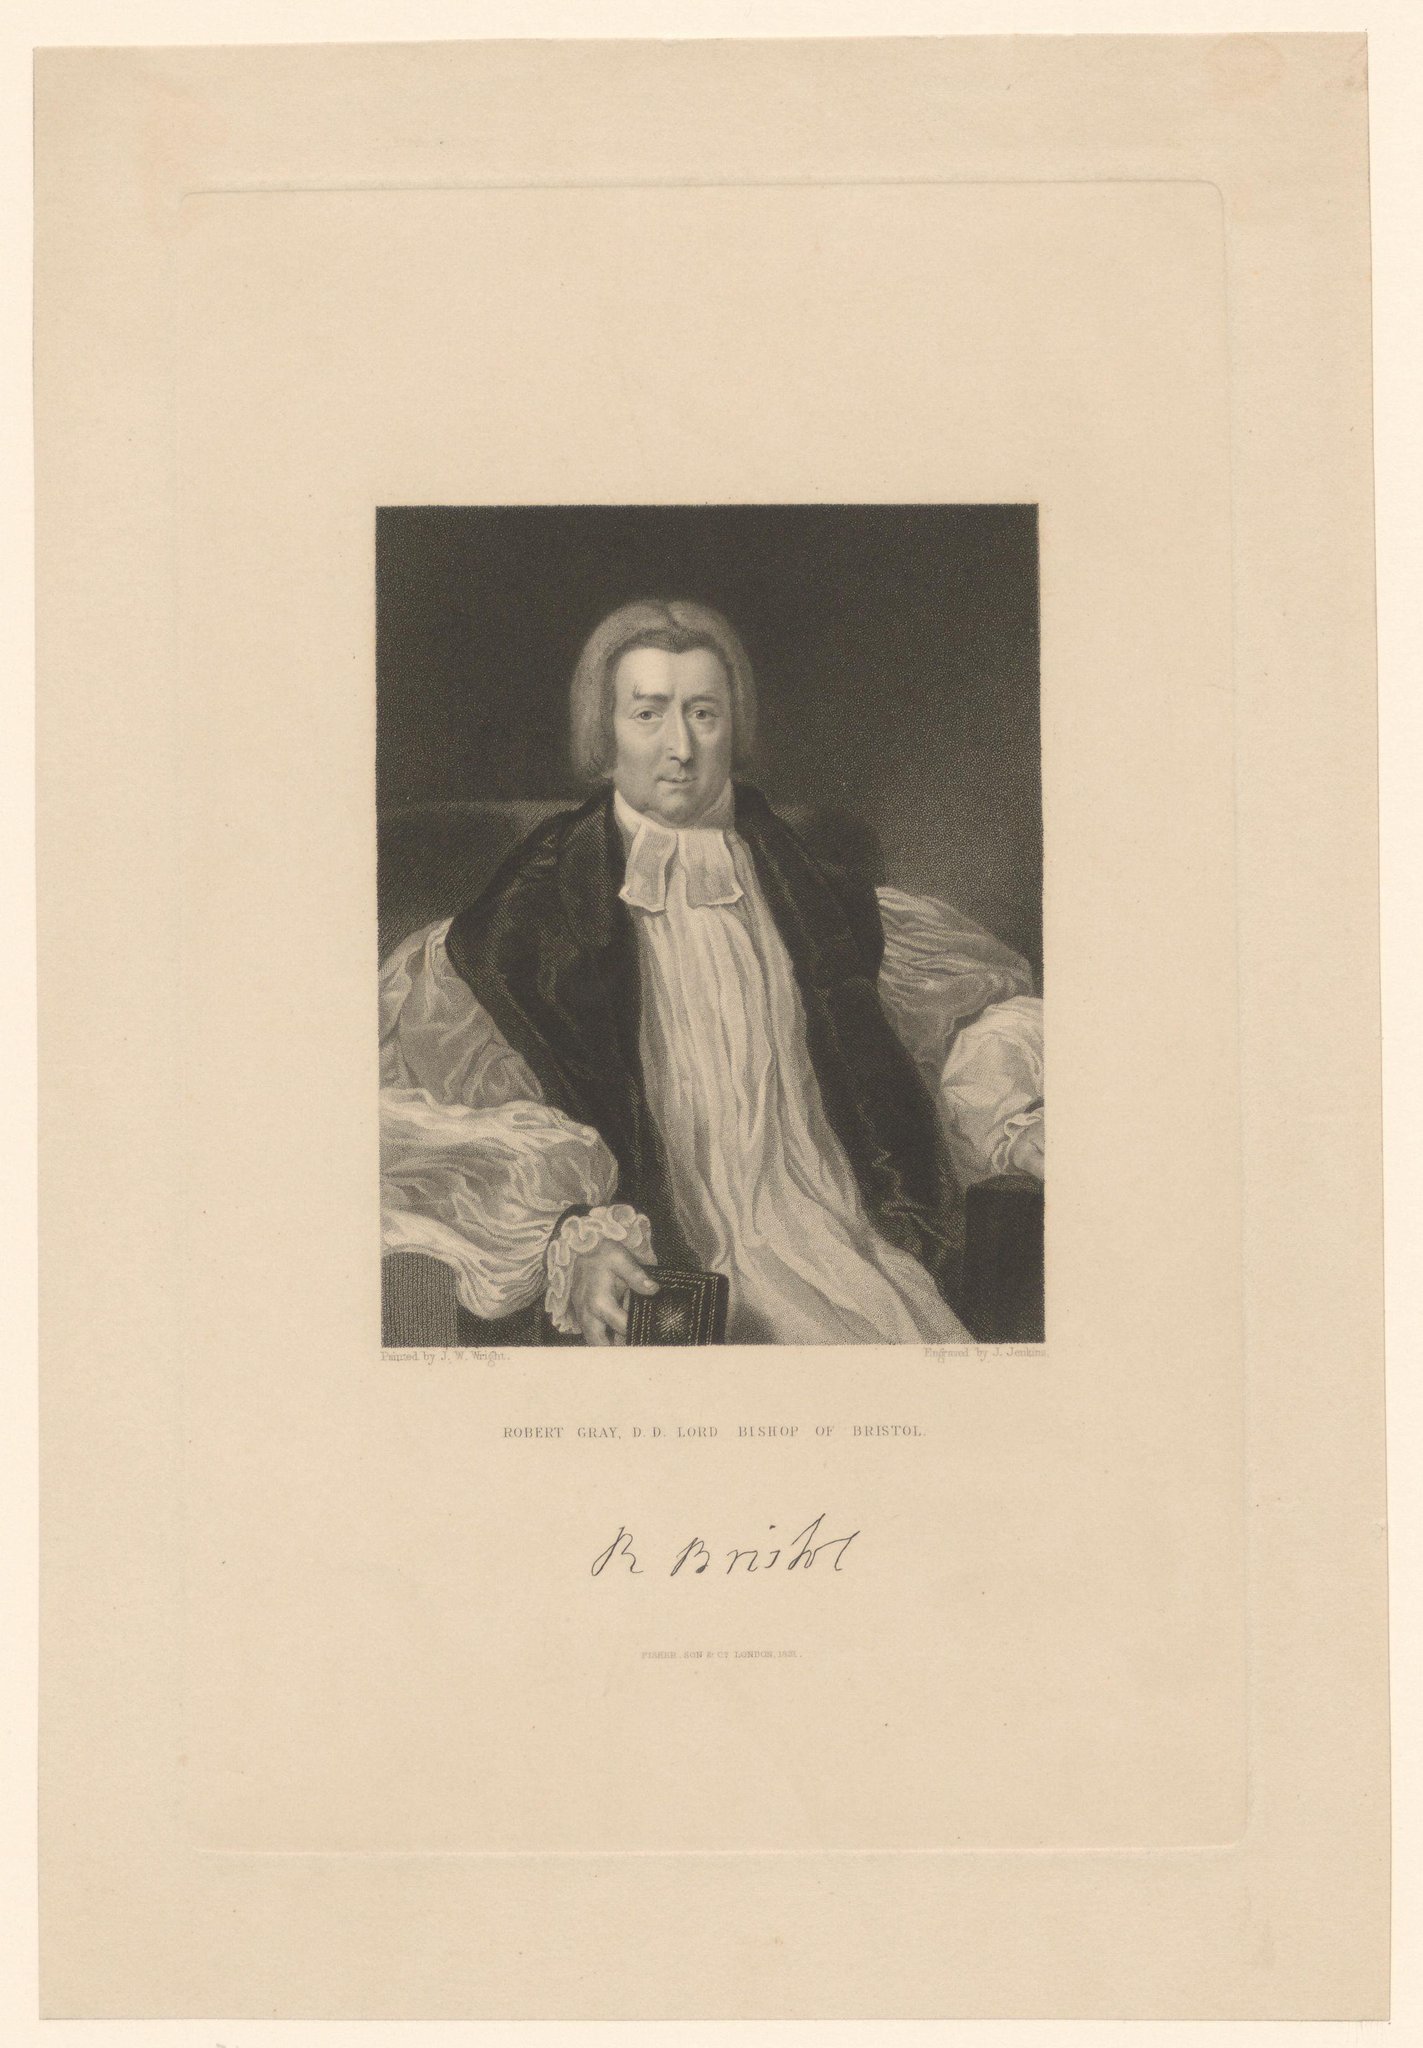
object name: print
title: Portret van Robert Gray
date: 1831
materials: paper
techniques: engraving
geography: london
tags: archbishop, bishop, etc. (roman catholic), historical persons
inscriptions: collector's mark: Lugt 2228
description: Een facsimile signatuur in de ondermarge.